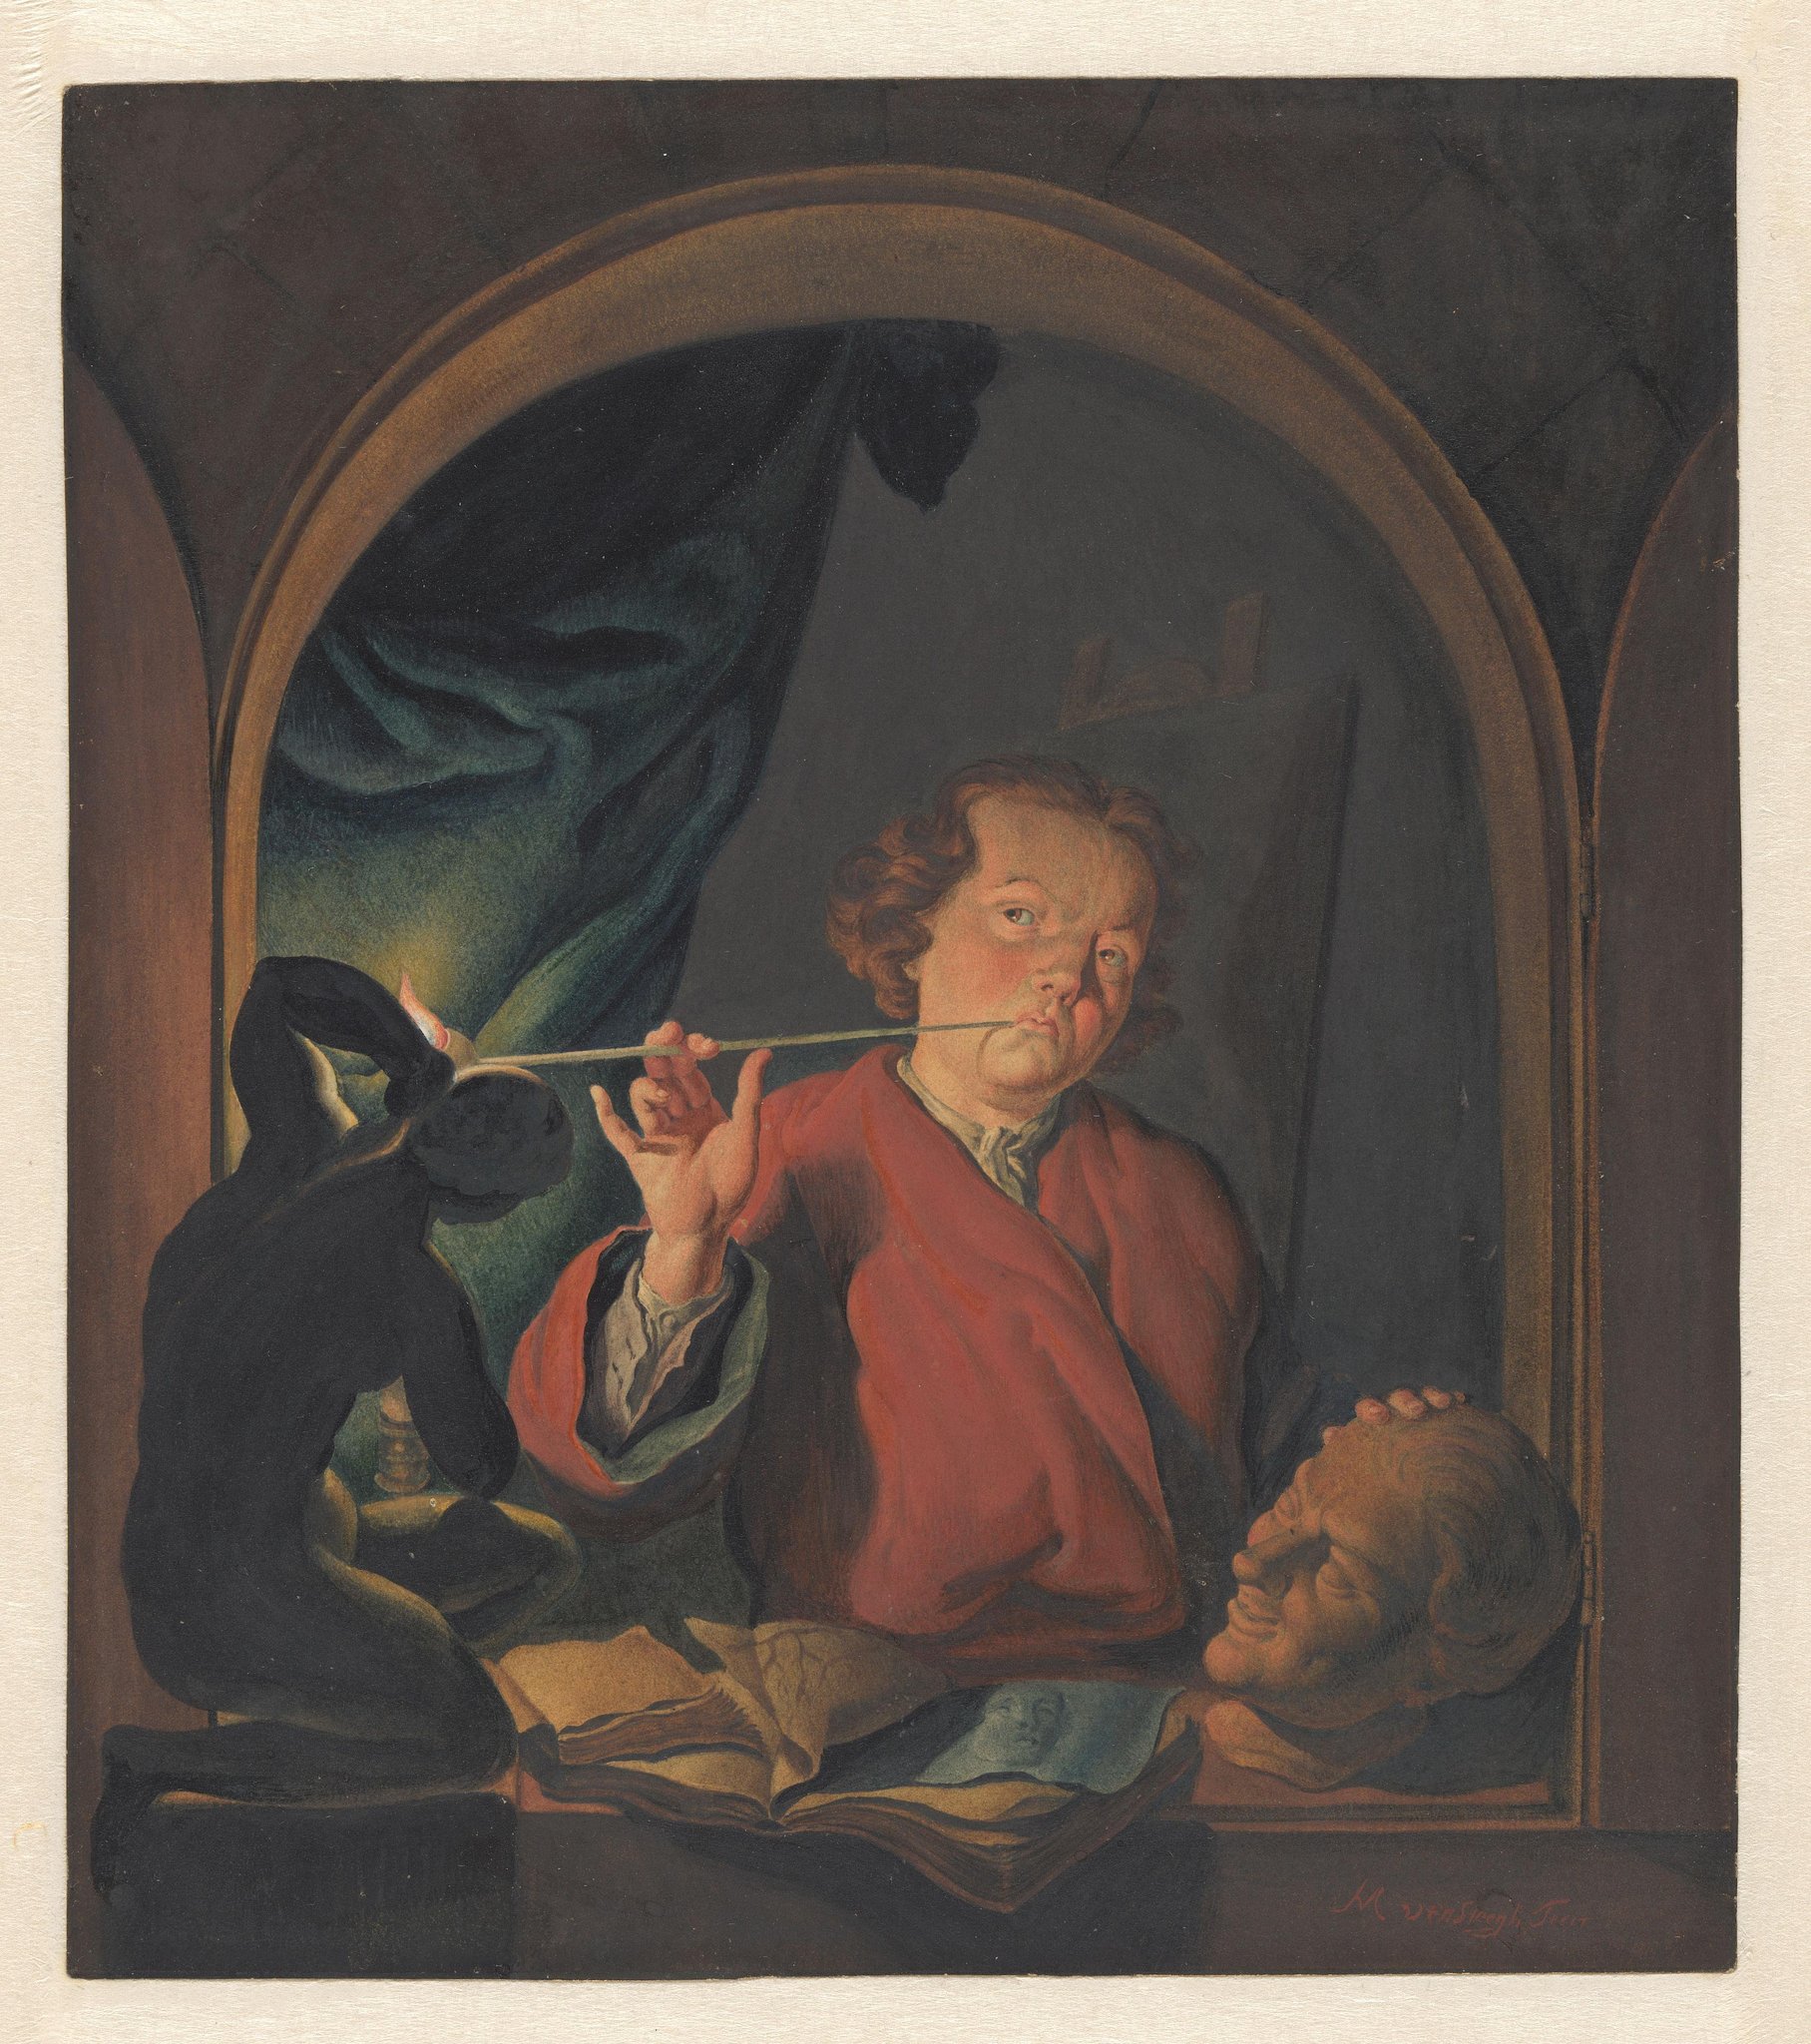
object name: drawing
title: Zelfportret van de kunstenaar, gezien achter een venster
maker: michiel versteegh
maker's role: painter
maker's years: 1756-1843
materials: paper, watercolor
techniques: brush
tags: dordrecht, painter, michiel versteegh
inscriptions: signature: ‘M. Versteegh Fecit’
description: Zelfportret van de kunstenaar met schildersezel, gebeeldhouwde kop, mogelijk van hemzelf, kunstboek met tekeningen, boek en gipsen beeld, bij kaarslicht